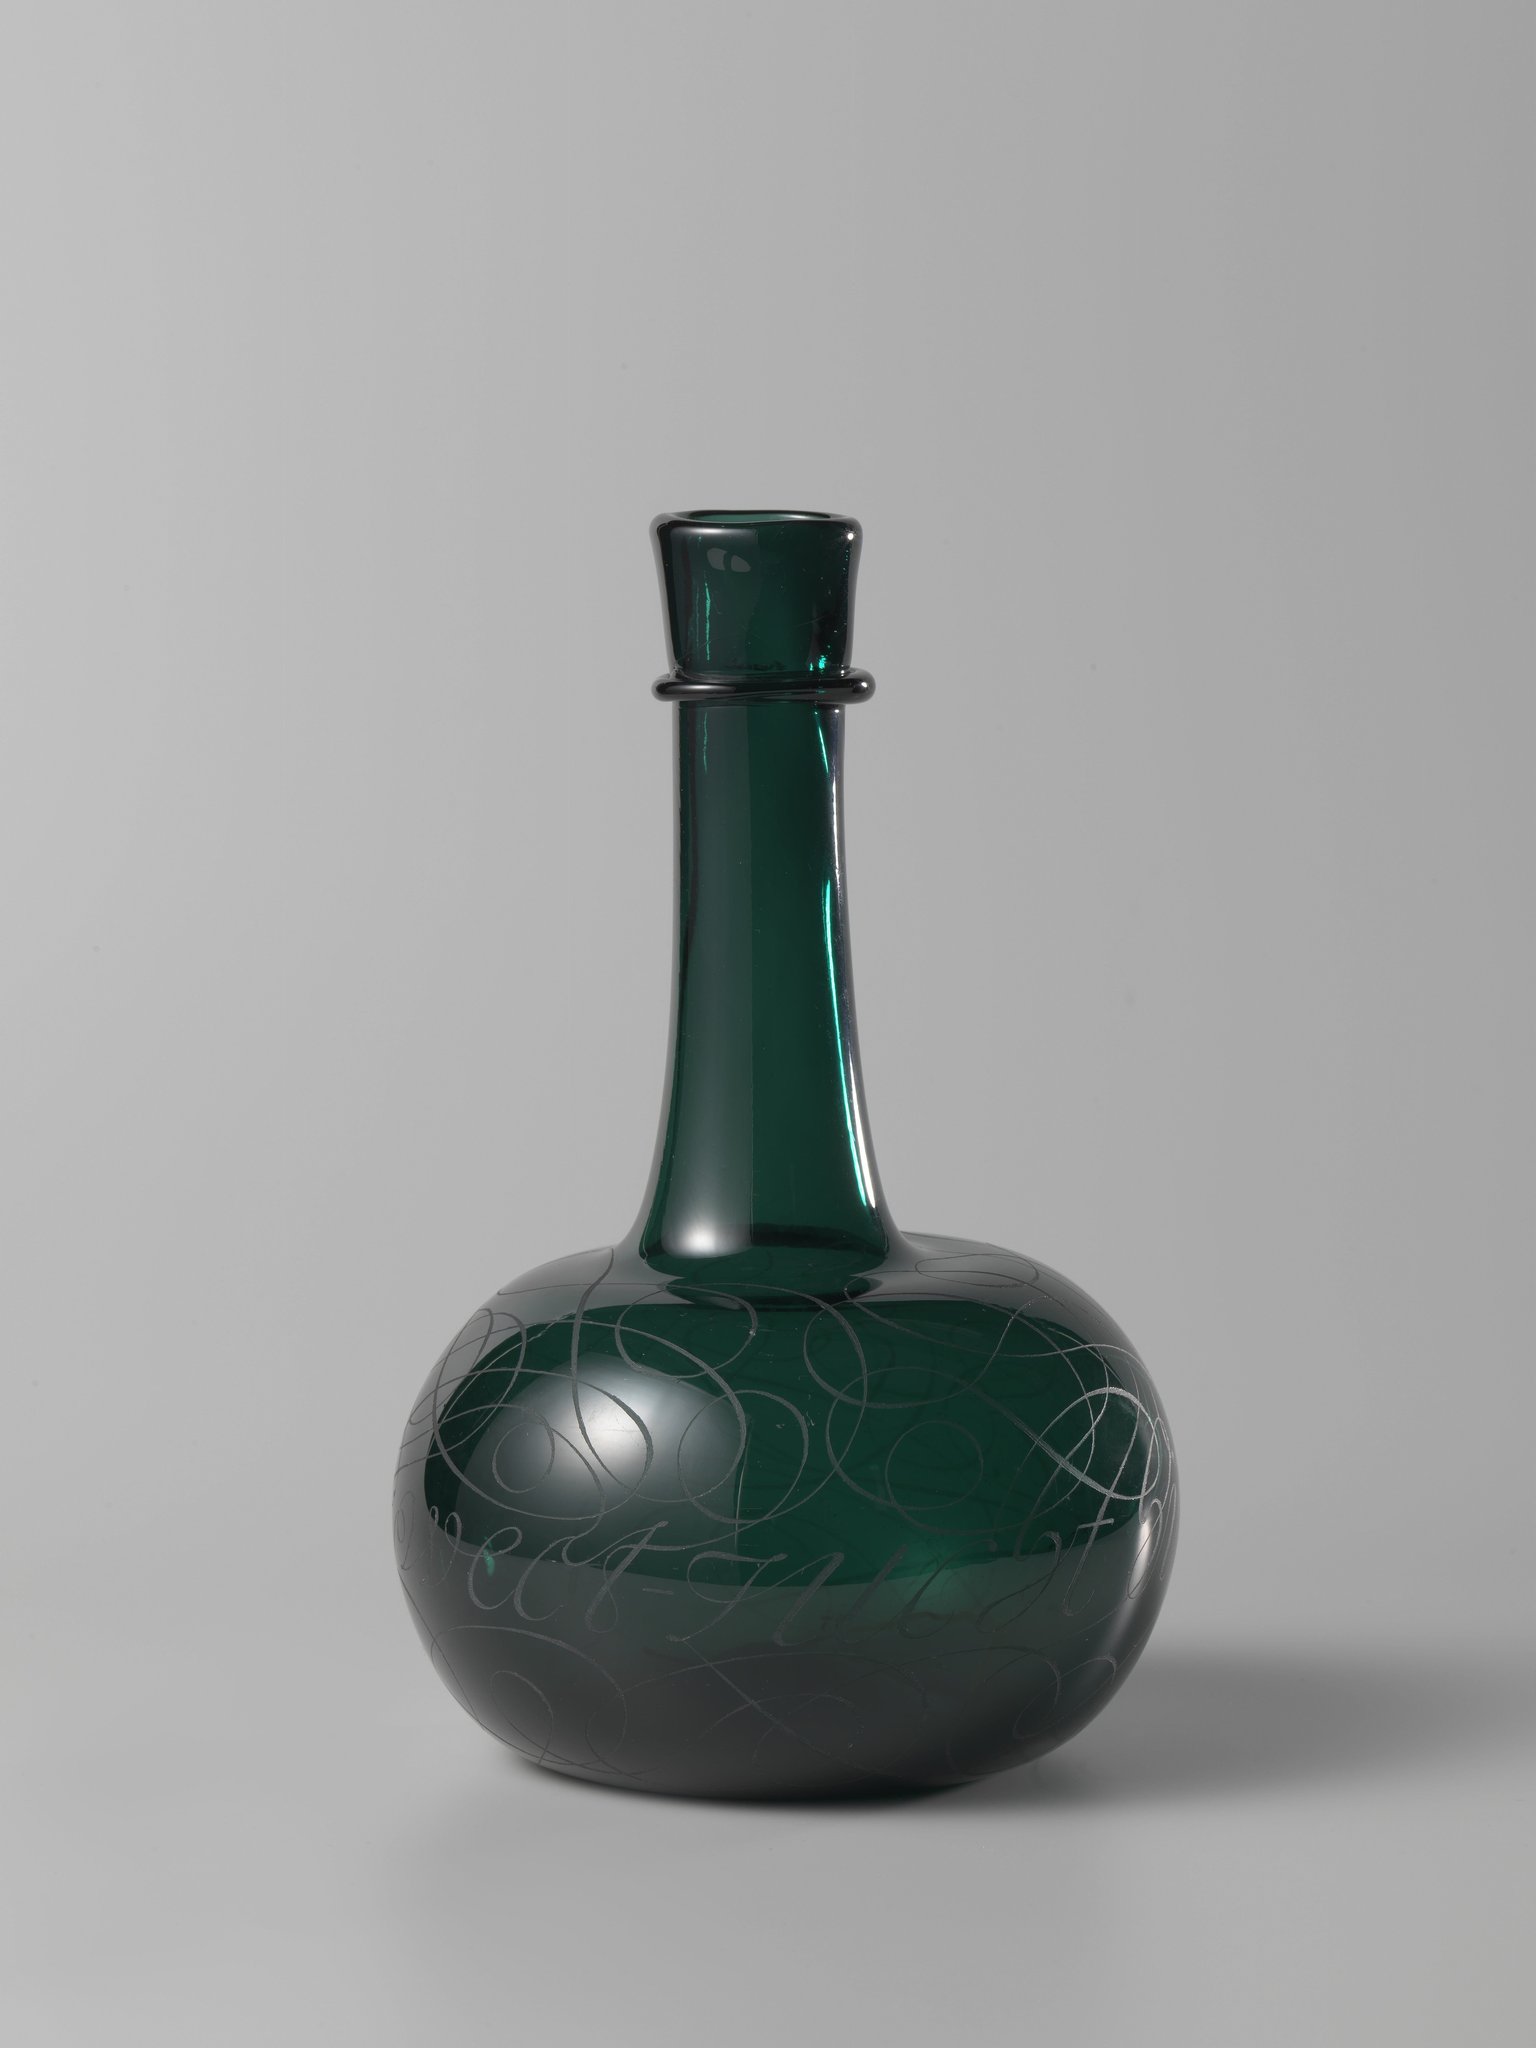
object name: bottle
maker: willem jacobszoon van heemskerk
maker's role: dichter, glasgraveur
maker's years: 1613-1692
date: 1680-1690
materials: glass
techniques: diamond point engraving, glassblowing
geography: leiden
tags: leiden, willem jacobszoon van heemskerk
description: The inscription translates as: ‘Vain curiosity is annoying’. In an inscription on the base, Van Heemskerk apologizes for the fact that his hand is no longer so steady; he is old.